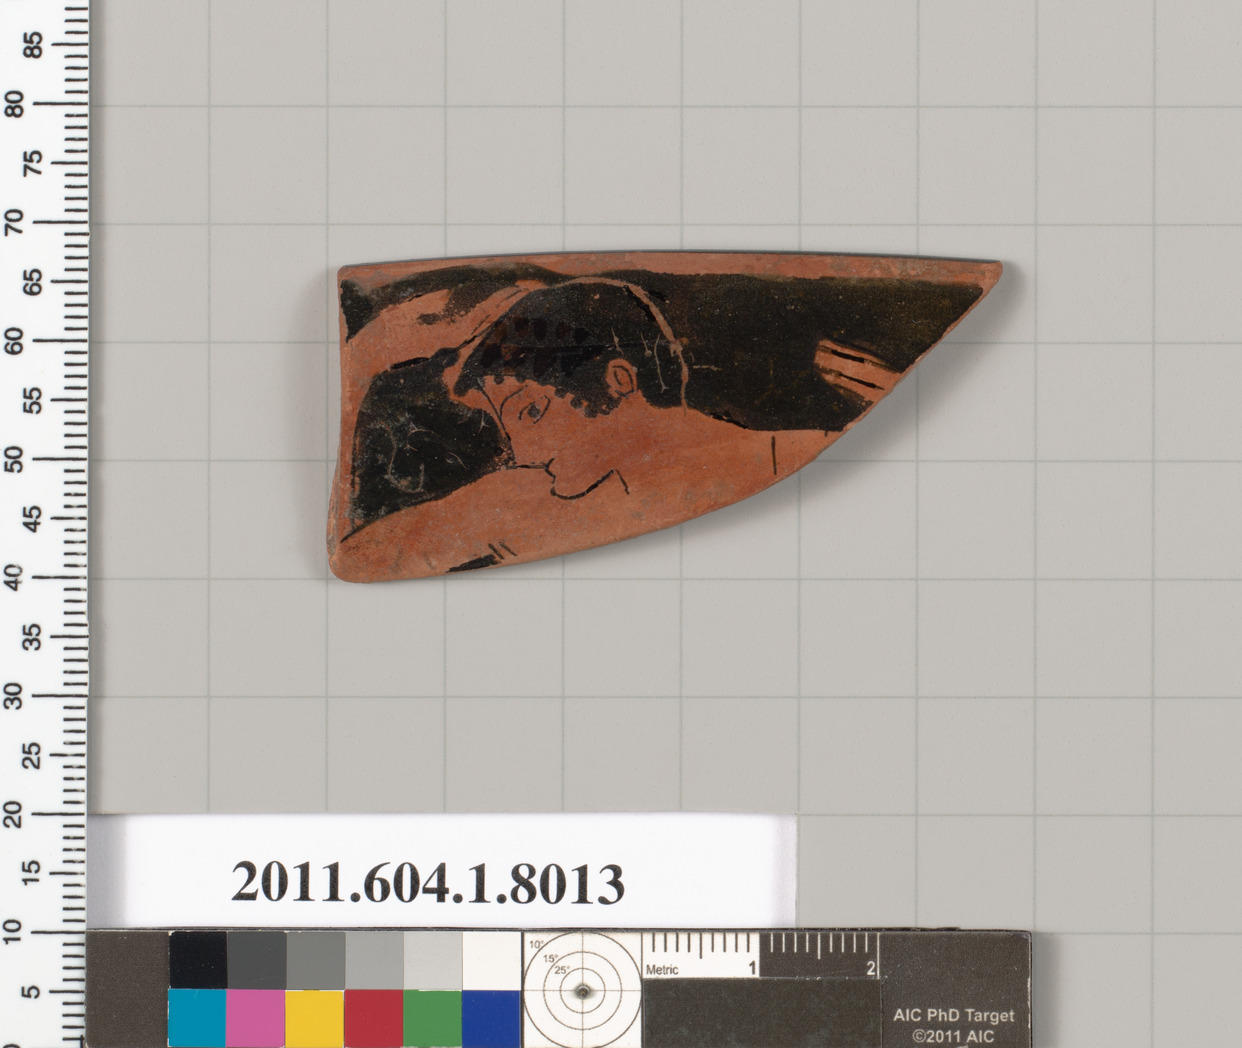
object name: kylix fragment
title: Terracotta rim fragment of a kylix (drinking cup)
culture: greek, attic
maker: euergides painter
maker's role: artist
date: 510-500 BCE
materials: terracotta